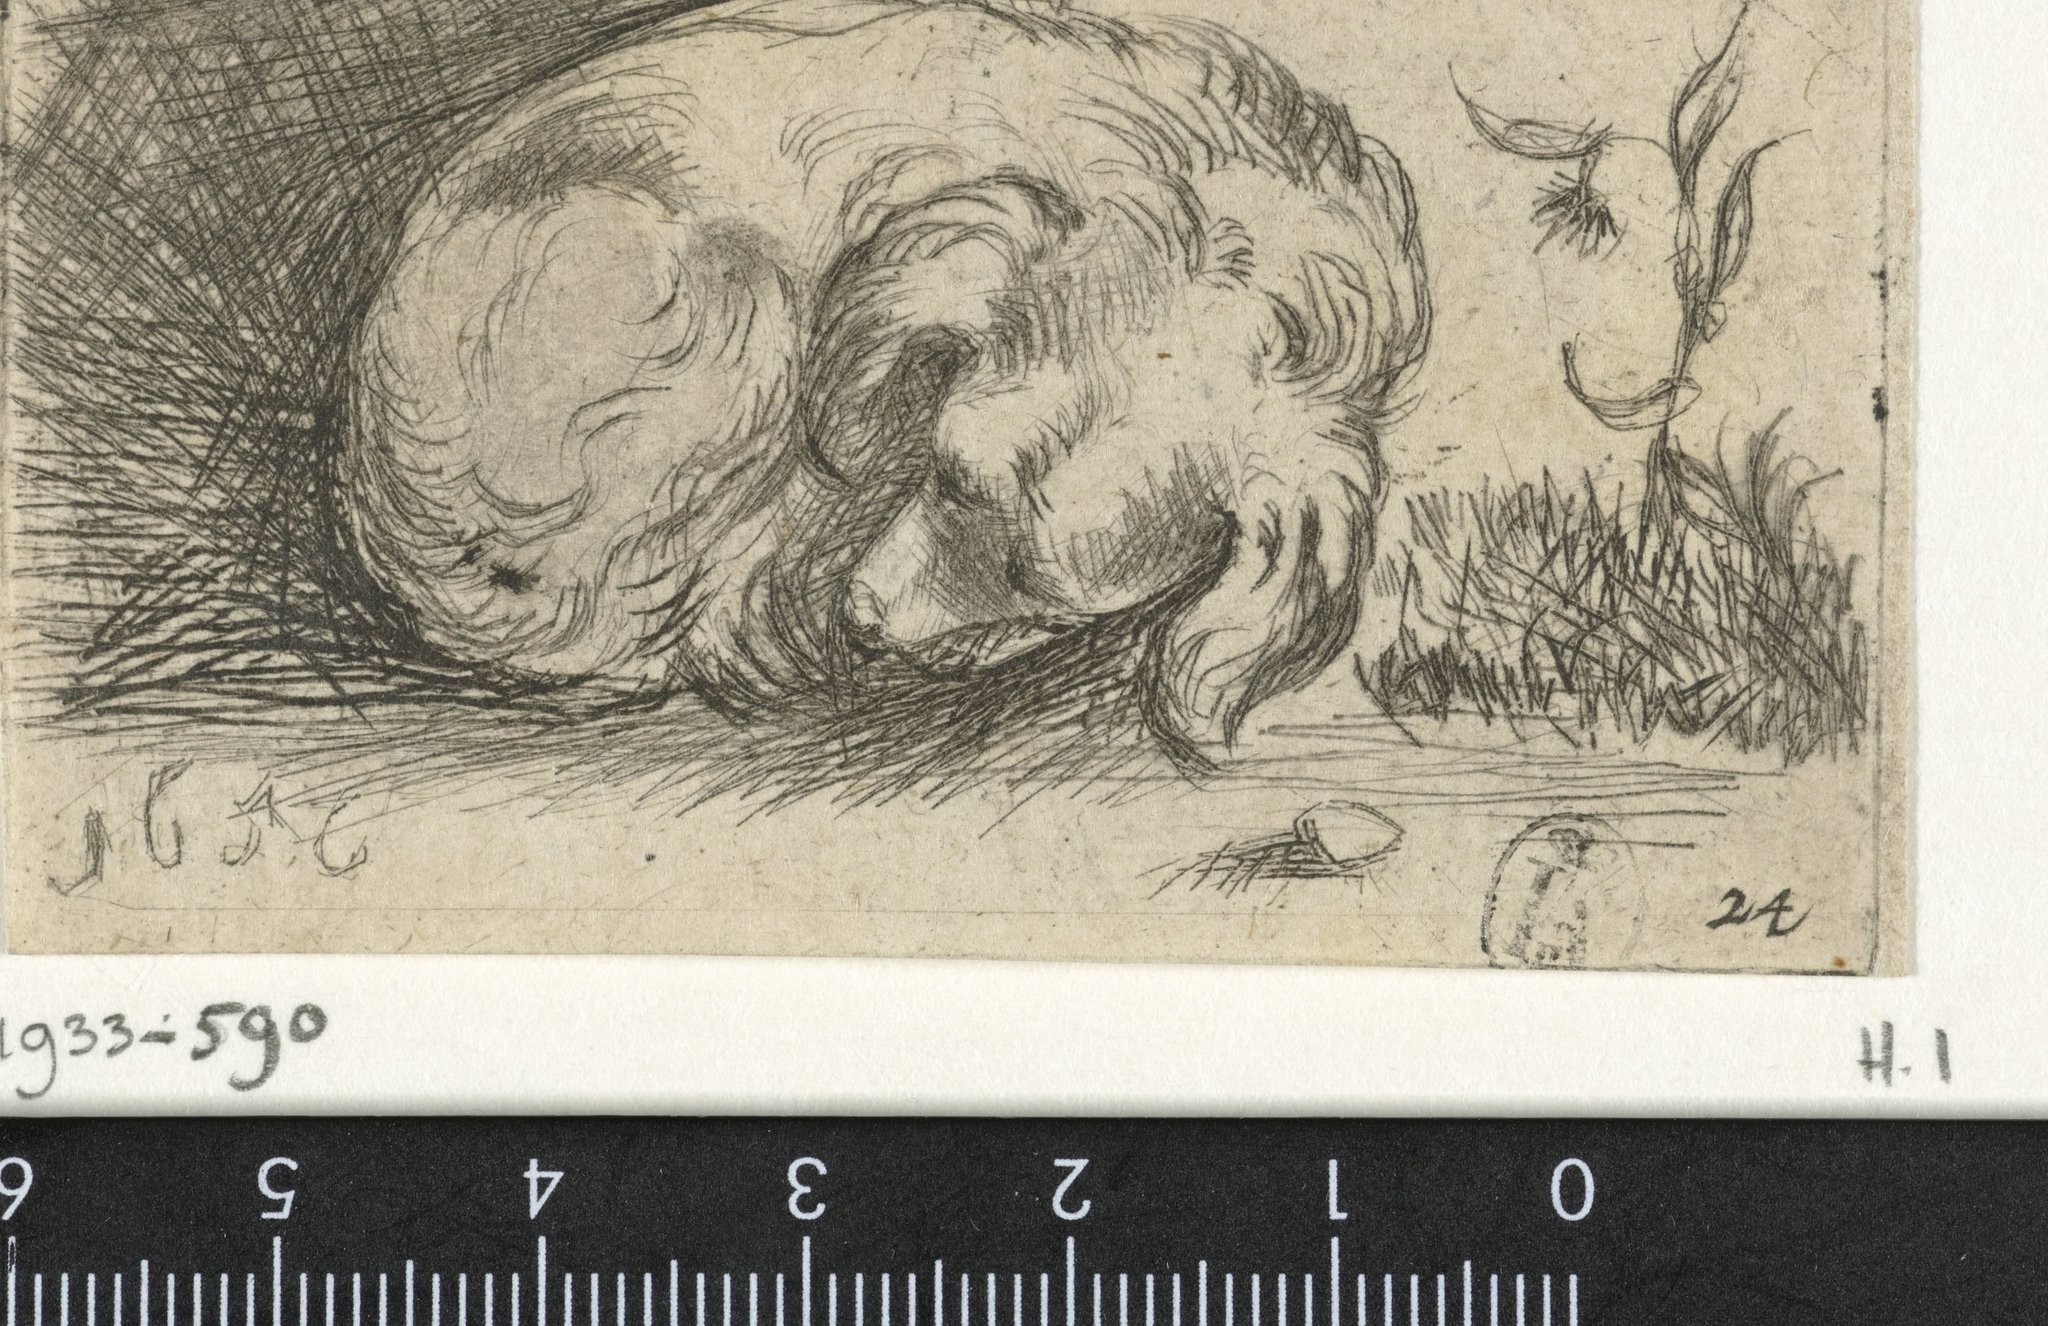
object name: print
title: Slapend hondje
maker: frans van mieris (i)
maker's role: draughtsman, painter, print maker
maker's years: 1635-1681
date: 1656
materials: paper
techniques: etching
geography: leiden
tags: dog (with name of kind)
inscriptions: collector's mark: Lugt 971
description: Een slapende hond, liggend voor een muurtje. Naast hem een bloem in het gras. Rechtsonder genummerd: 24.